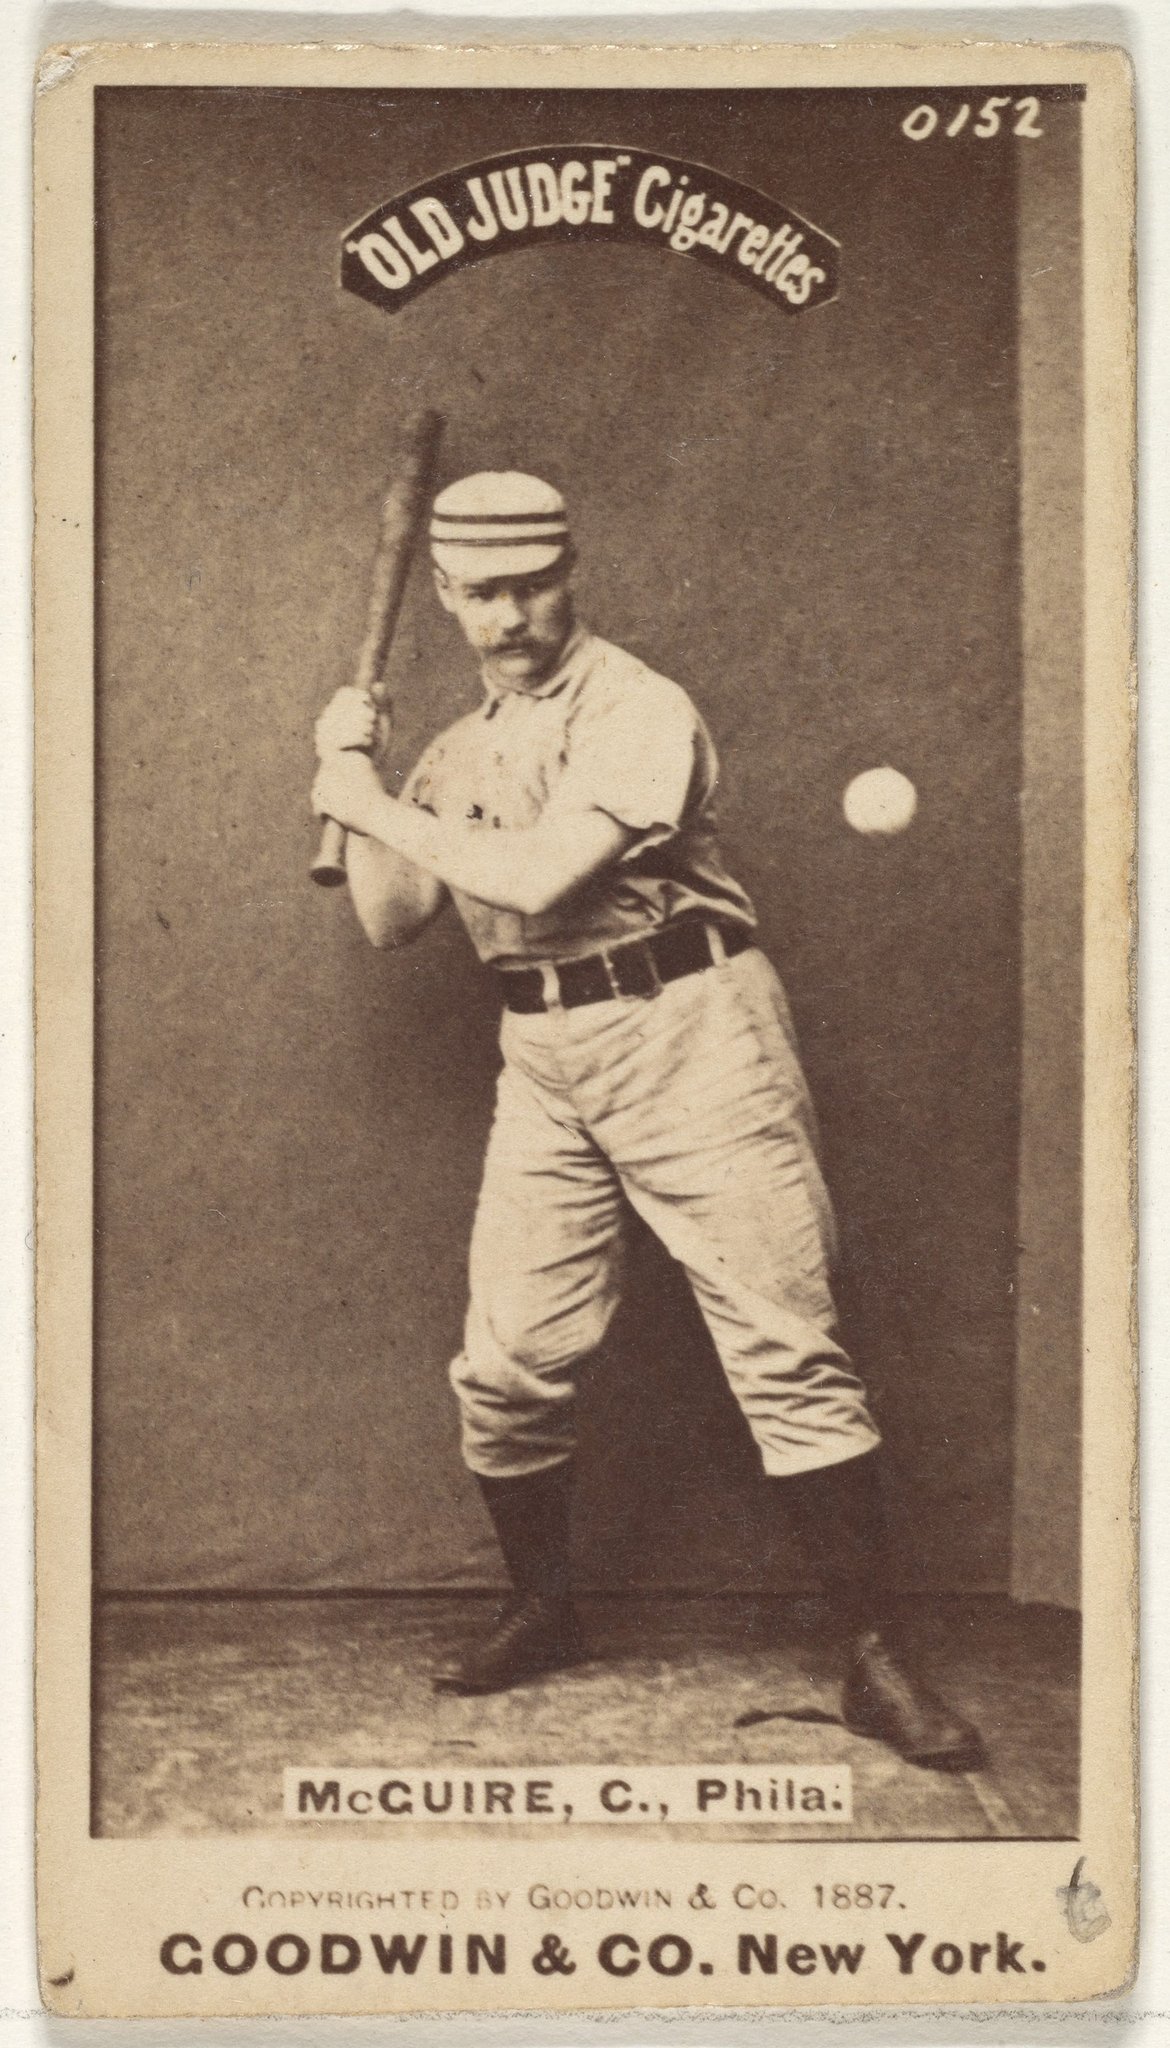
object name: baseball card, photograph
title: James Thomas "Deacon" McGuire, Catcher, Philadelphia, from the Old Judge series (N172) for Old Judge Cigarettes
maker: goodwin & company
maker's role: publisher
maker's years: 1850-1950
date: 1887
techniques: albumen silver print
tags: men,portraits,baseball,athletes